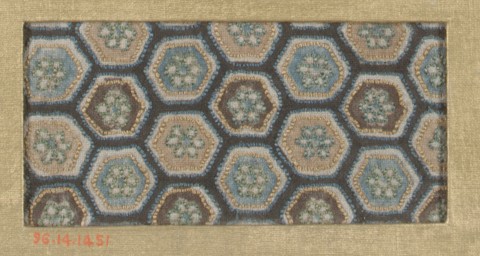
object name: piece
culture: japanese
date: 1701-1900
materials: silk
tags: flowers